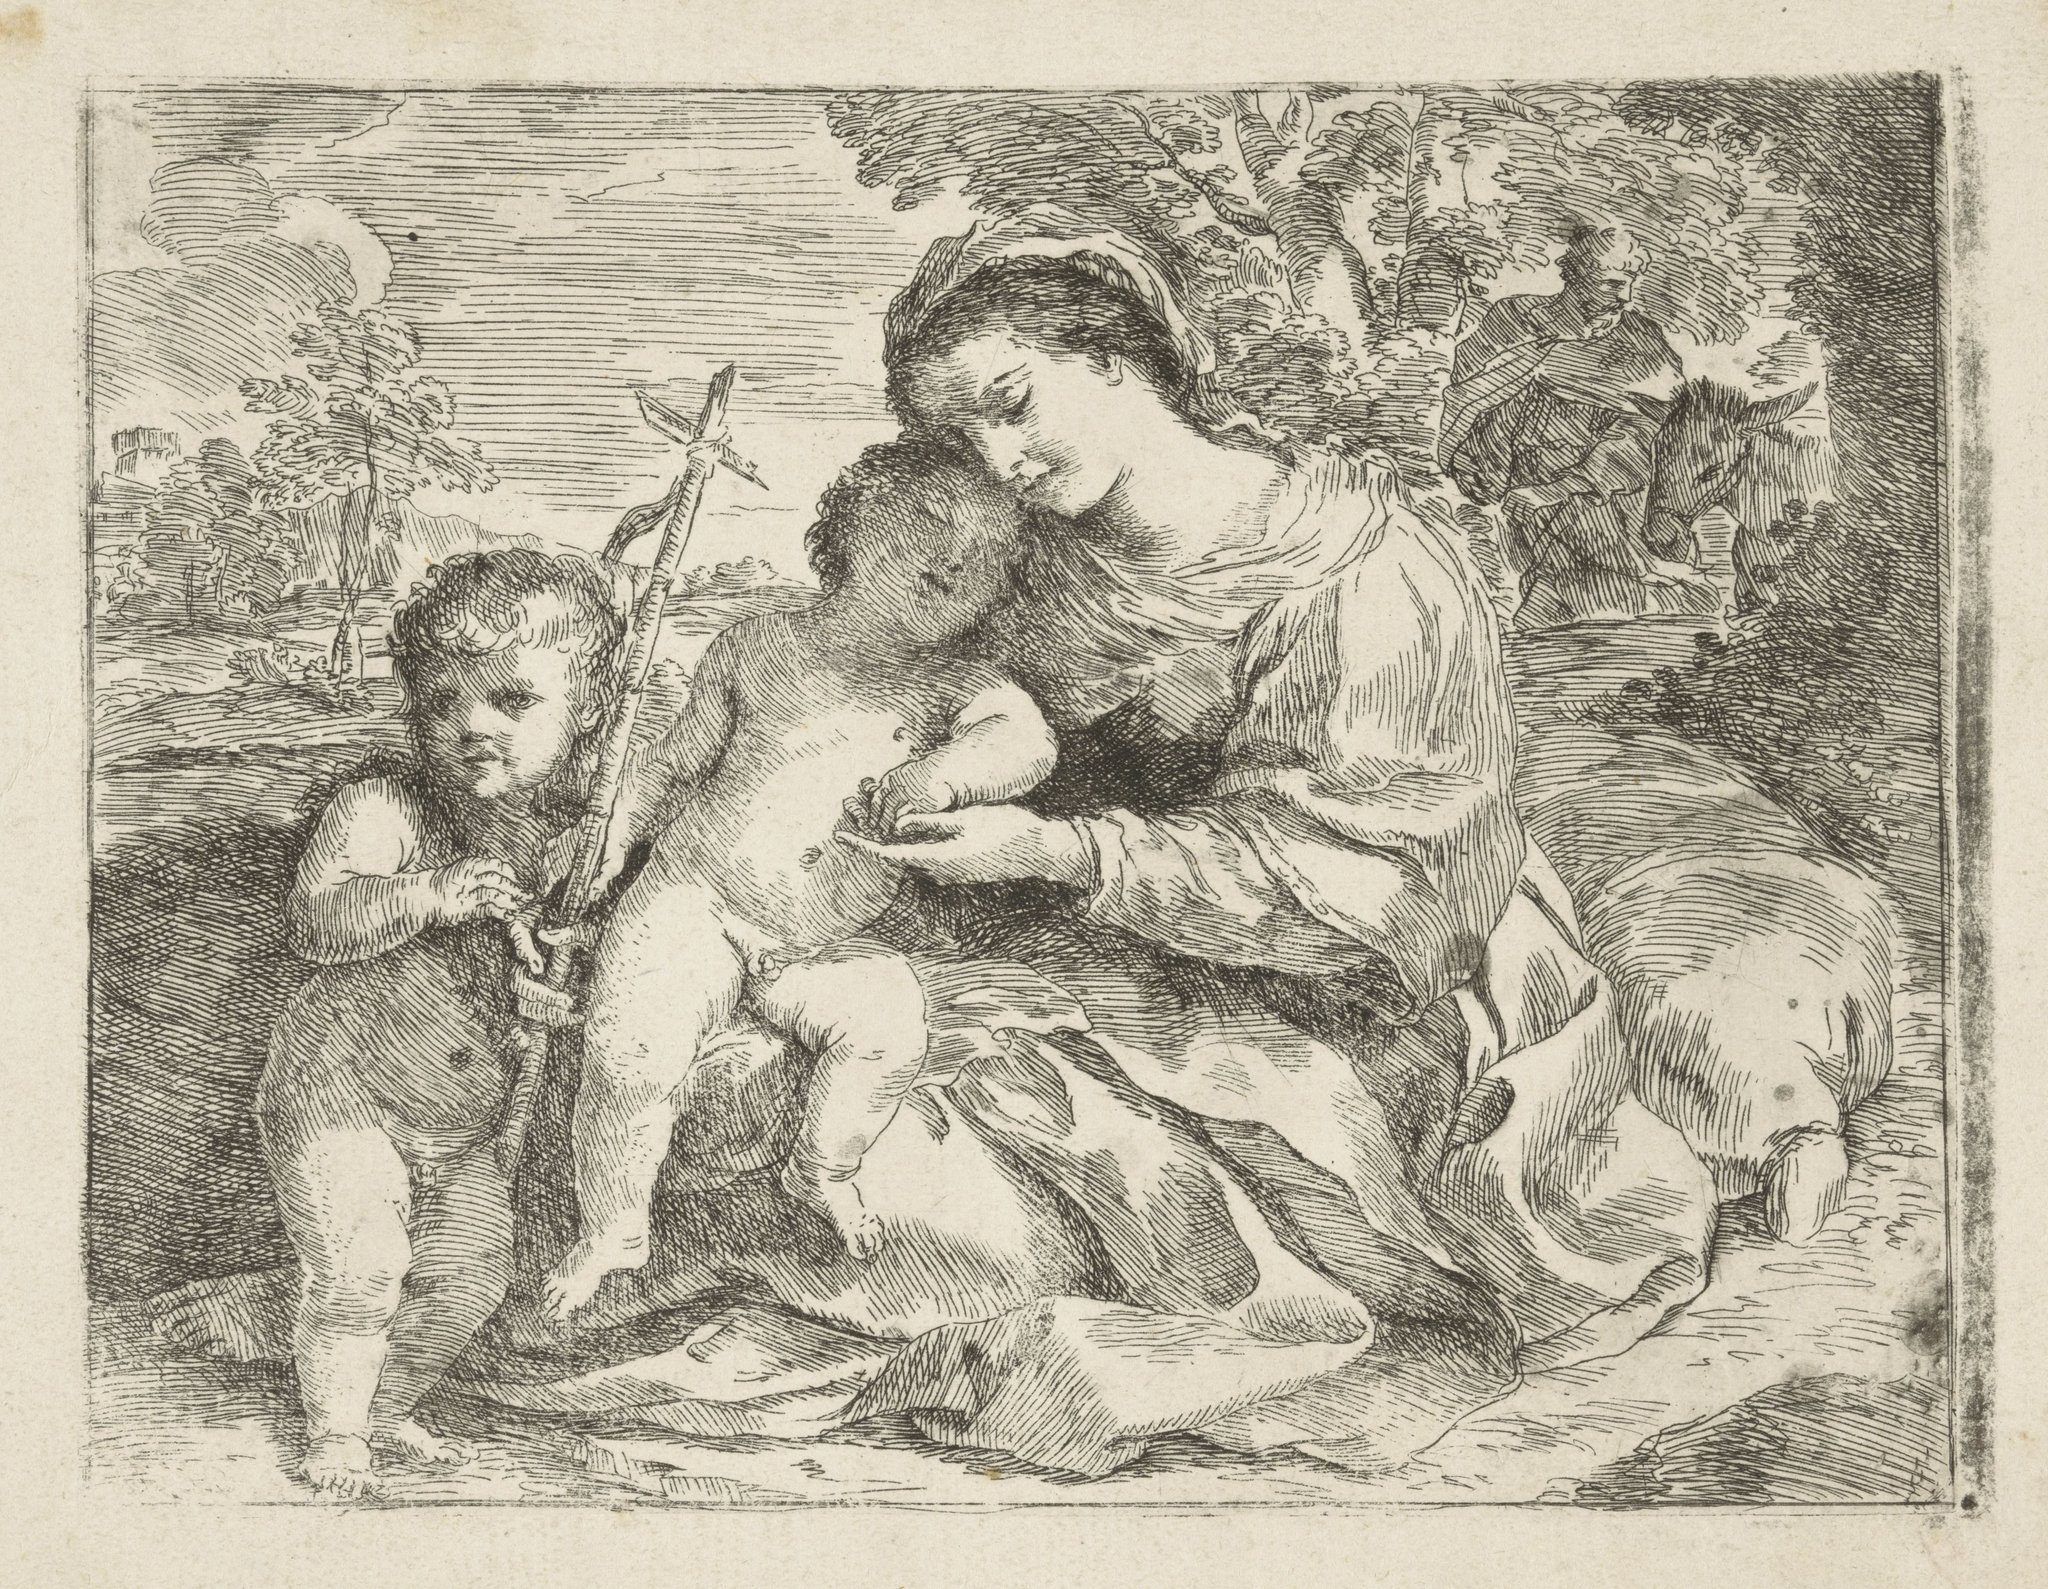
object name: print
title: Heilige Familie met de jonge Johannes de Doper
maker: andrea camassei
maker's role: print maker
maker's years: 1602-1649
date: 1612-1649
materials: paper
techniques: etching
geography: italy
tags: holy family with john the baptist (as child)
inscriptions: collector's mark: Lugt 240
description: Maria zit in een landschap met het Christuskind op schoot. Johannes de Doper leunt tegen hen aan. Op de achtergrond rechts Jozef en een ezel.